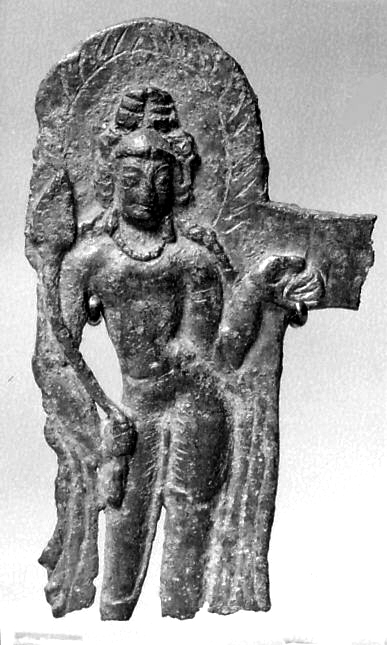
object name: halo element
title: Attendant Figure from a Halo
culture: pakistani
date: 801-900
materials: bronze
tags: swat valley,men